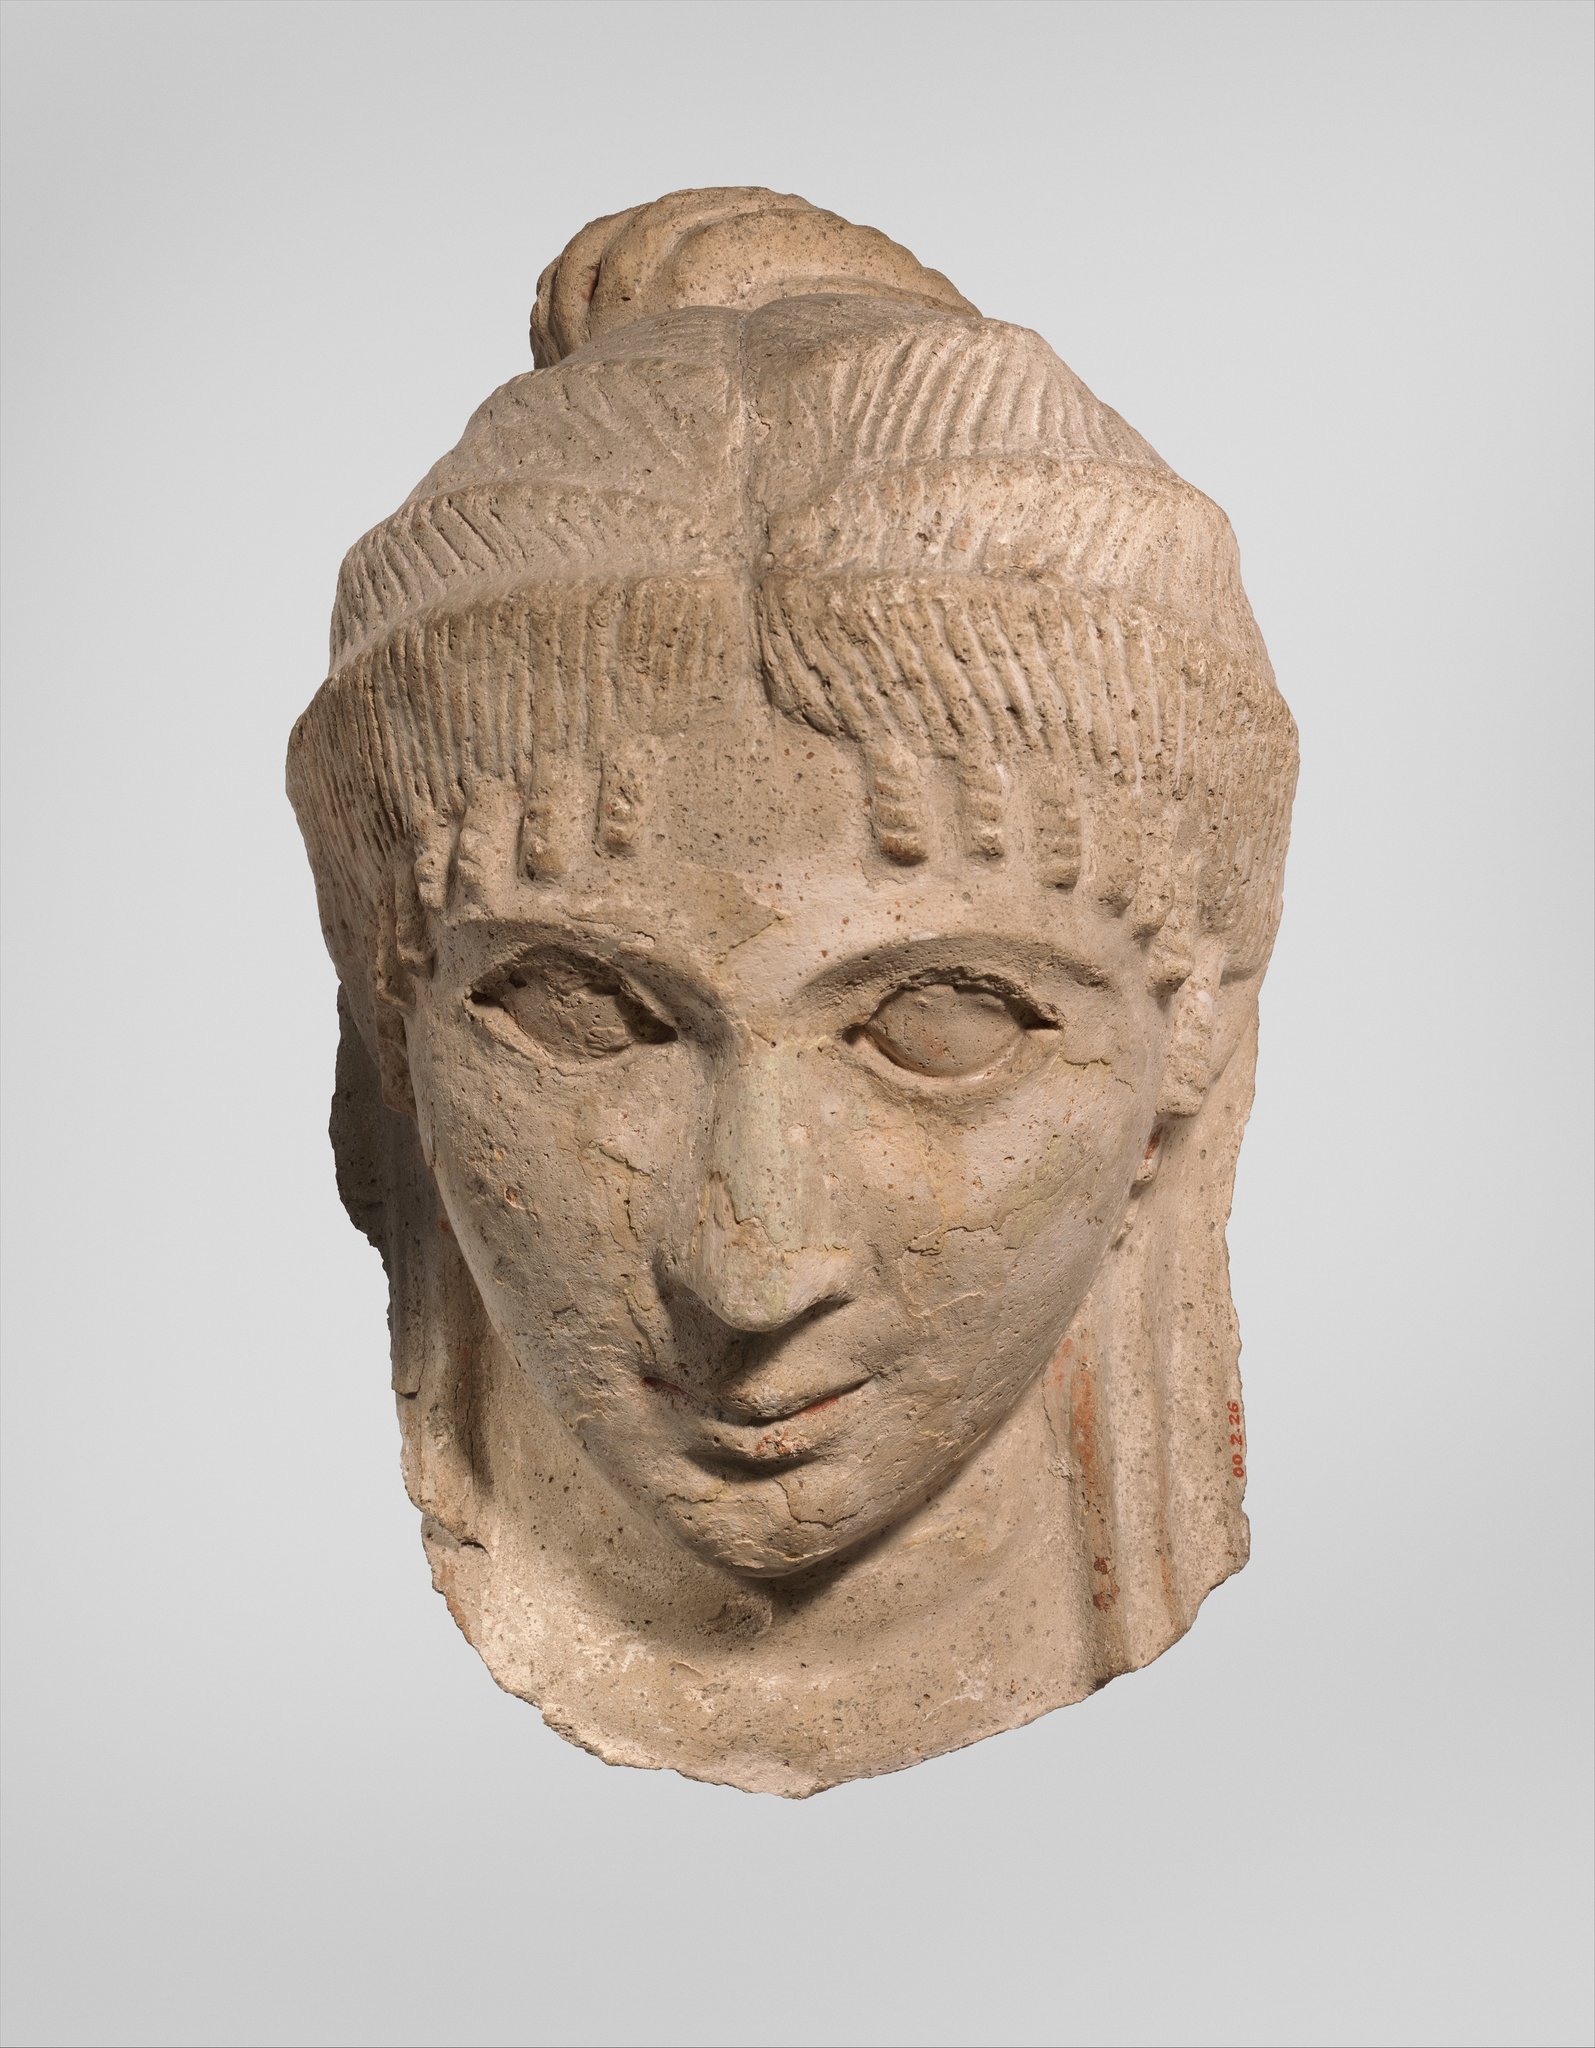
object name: mask of a woman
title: Funerary Mask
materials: paint, plaster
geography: egypt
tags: masks